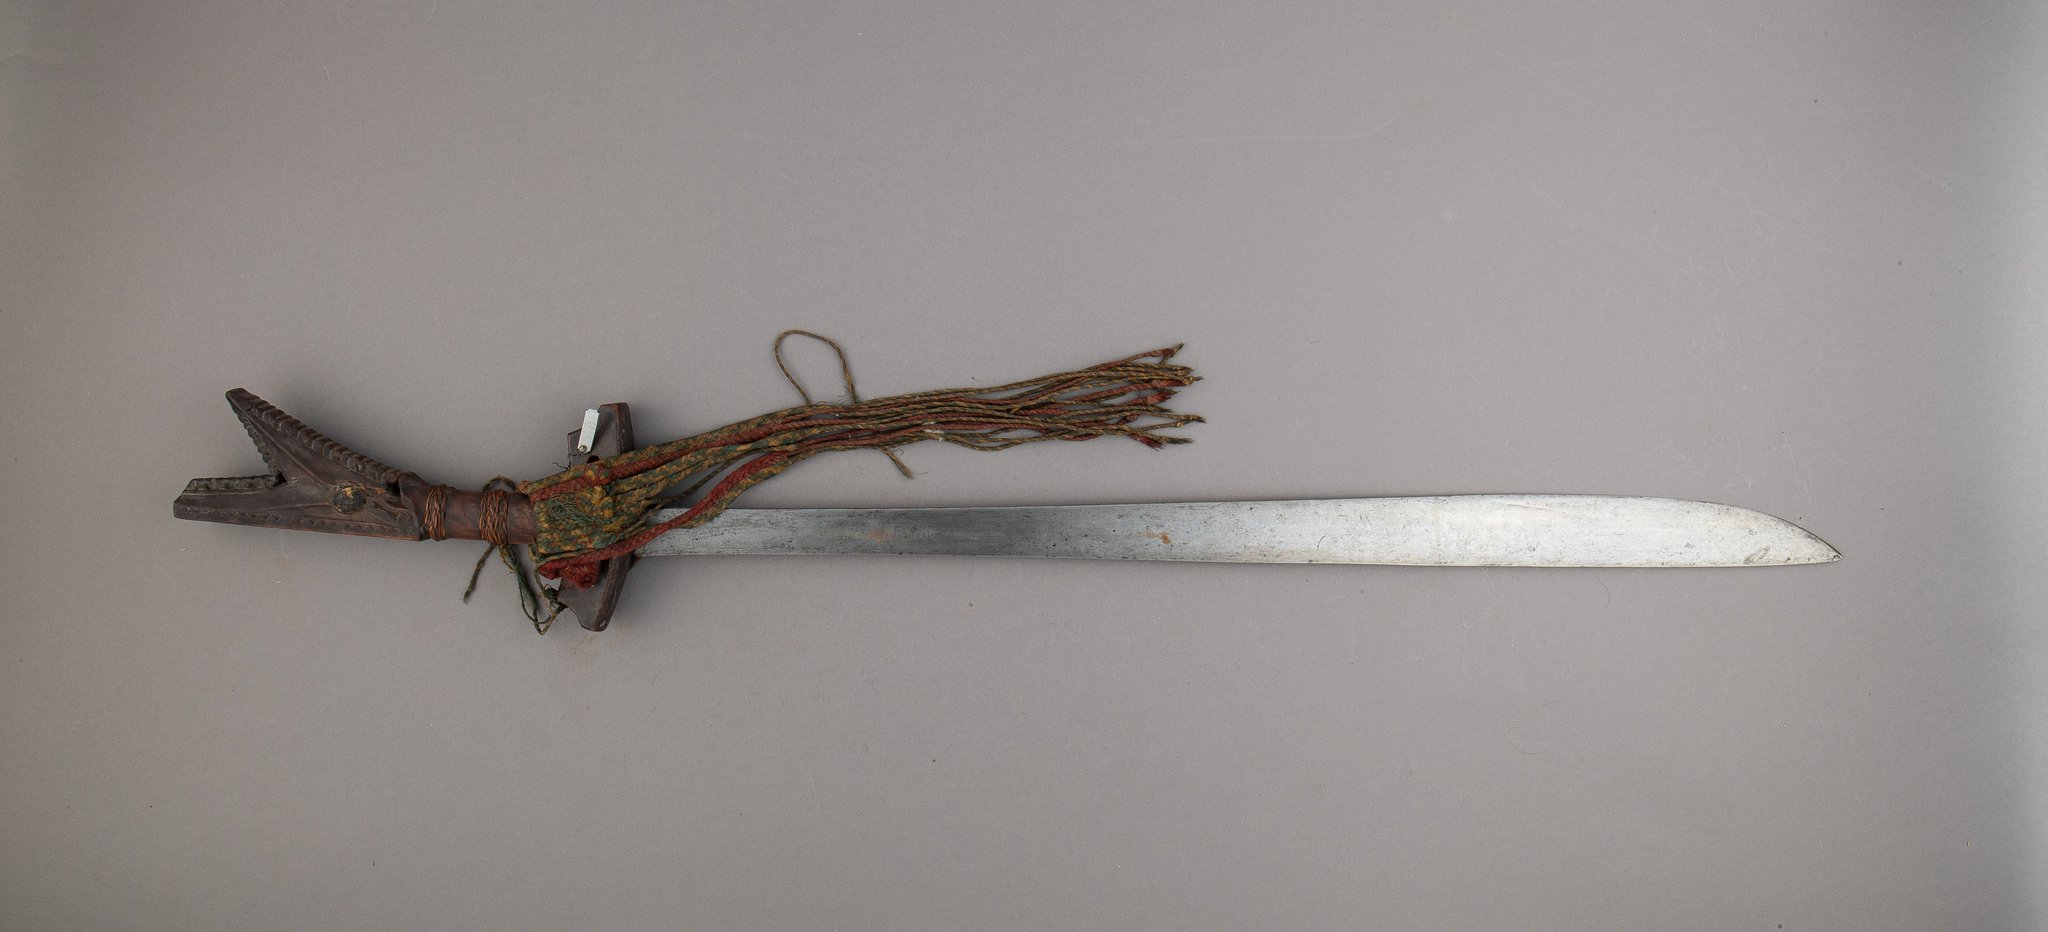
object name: sword campilan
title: Sword (Campilan)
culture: malayan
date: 1701-1900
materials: textile, wood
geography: malaysia